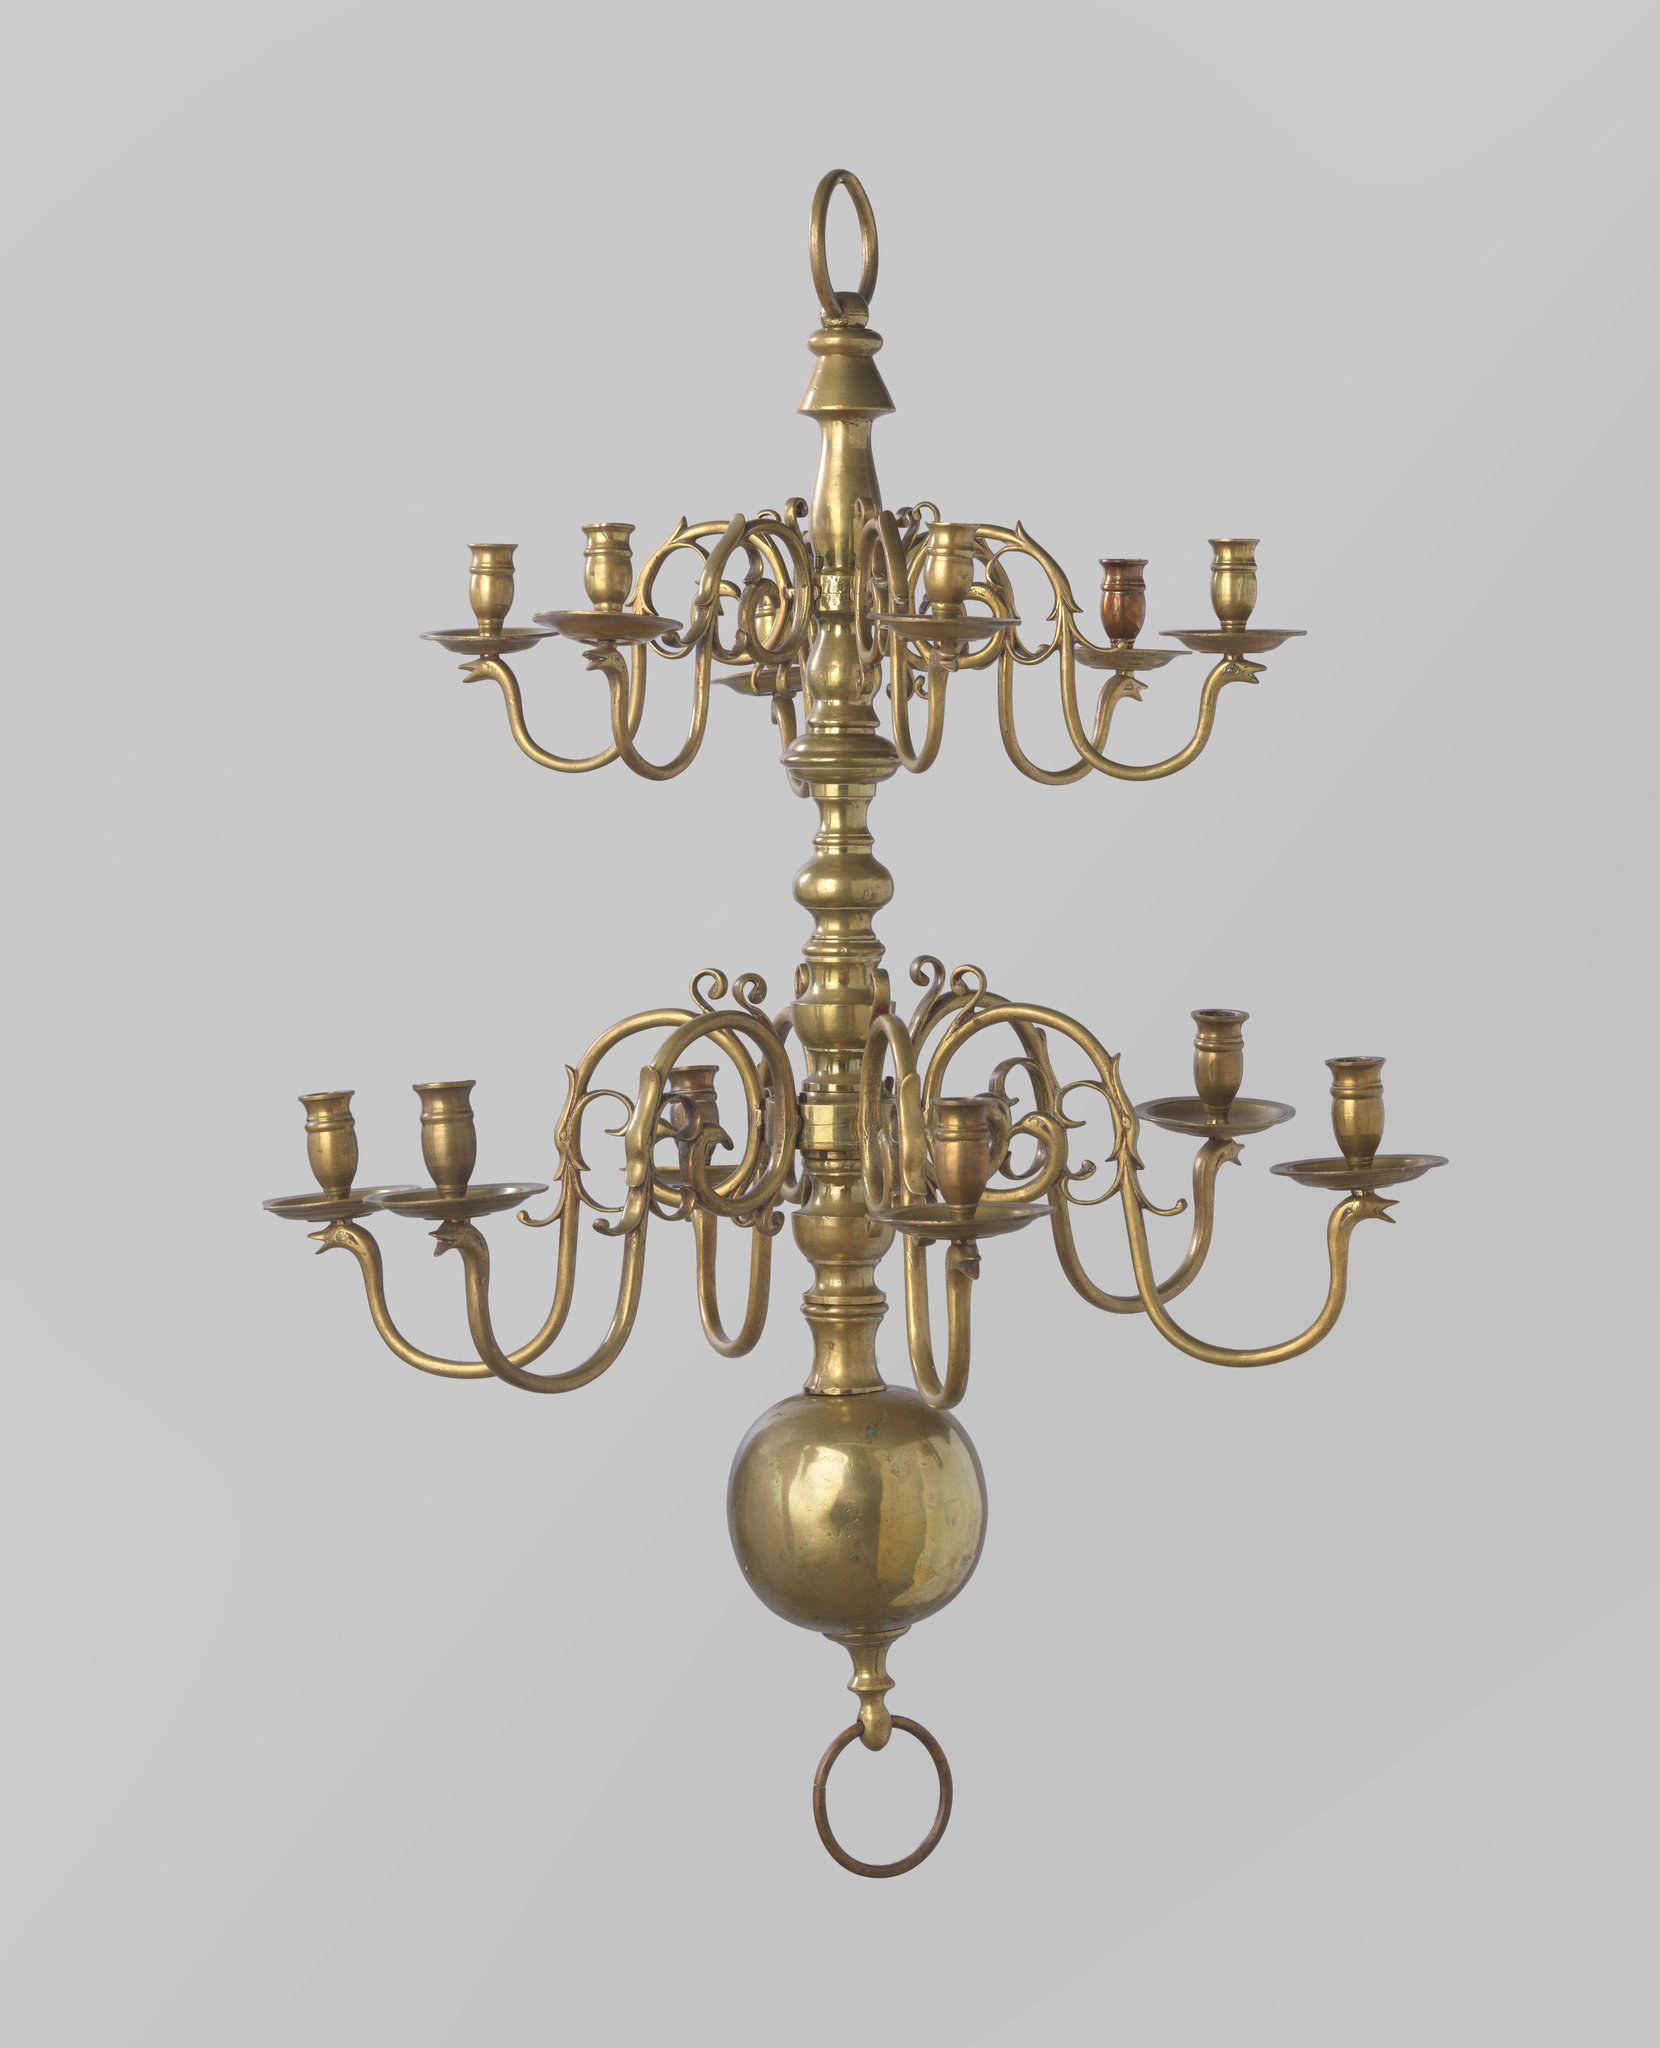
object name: chandelier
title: Arm van een kaarsenkroon in twee hoogten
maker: Anonymous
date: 1890-1910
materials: brass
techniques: casting, screwed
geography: netherlands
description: De arm heeft een S-vorm, naar buiten toe eindigend in een slangenkop en op het andere eind in vogelkop. De arm is aldaar met krullen versierd. Er is schroefdraden aangebracht in het uitsteeksel aan de kaarsenhouder, de arm of op het einde van de verbindingsstang. In het midden heeft de arm tevens een gestileerde dierenkop. Dit is de eerste arm van de onderste standring, genummerd met het cijfer 1.